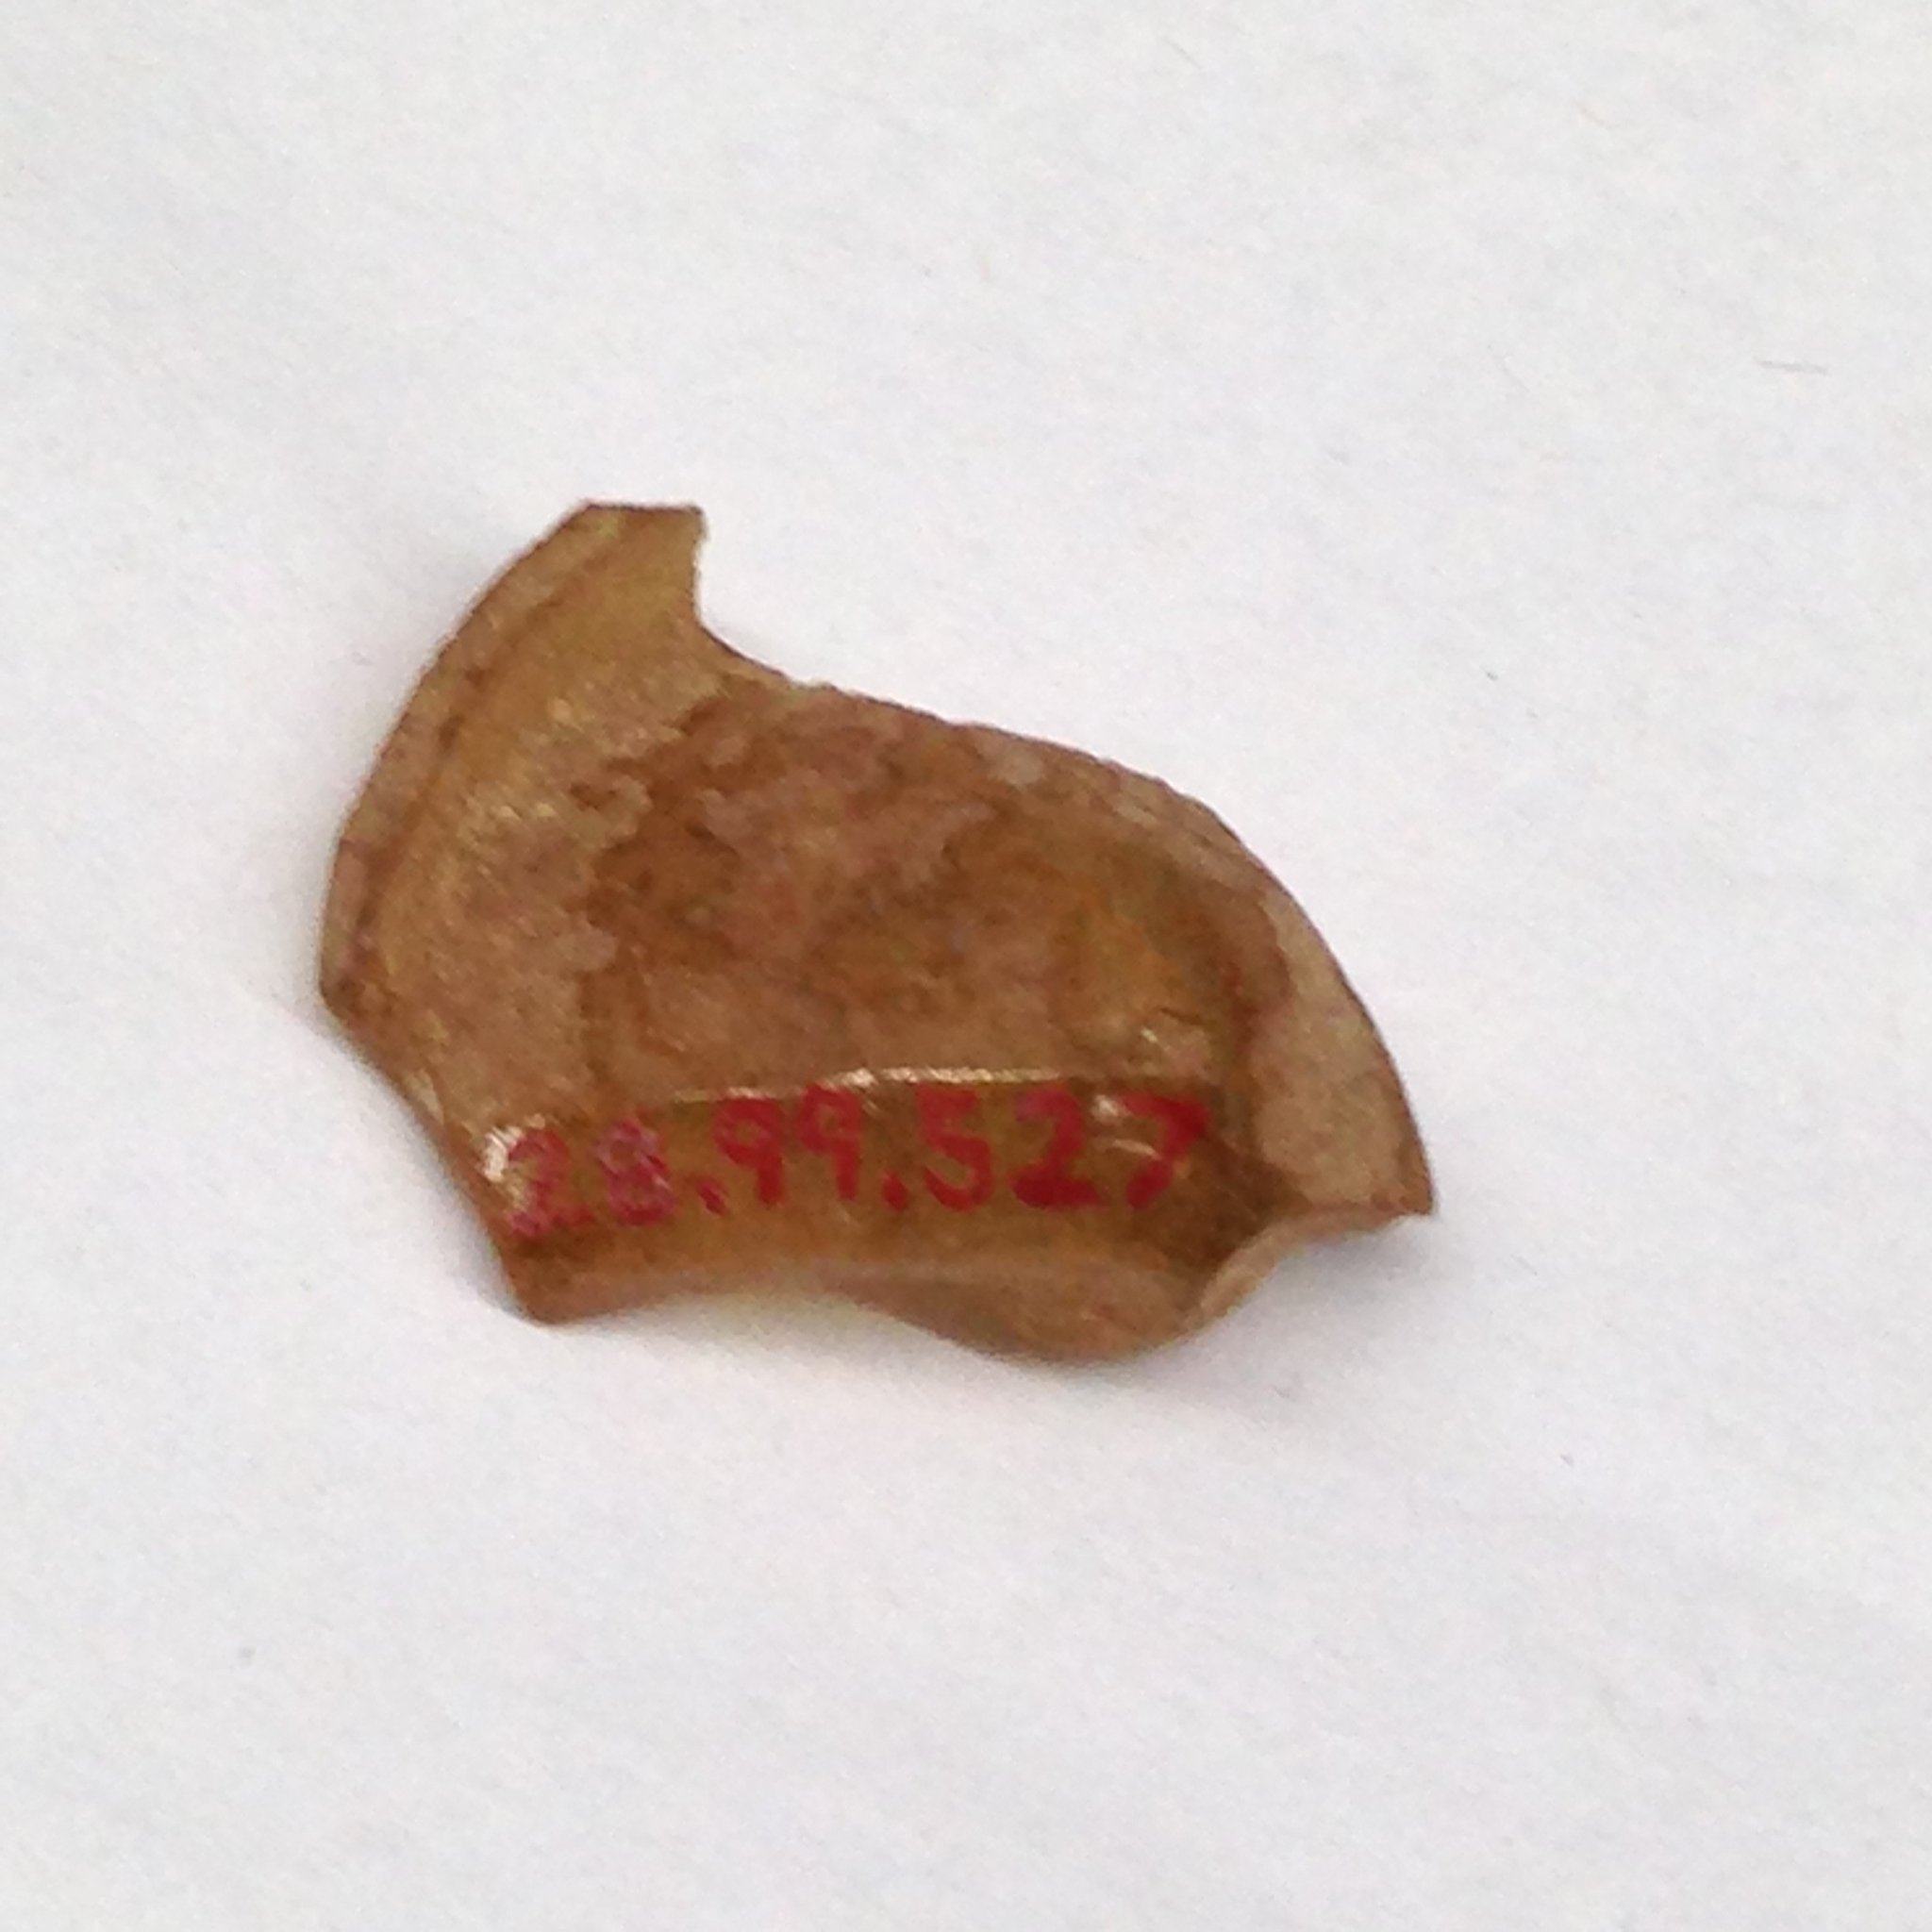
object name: fragment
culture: european or middle eastern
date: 1150-1250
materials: ceramic, glass